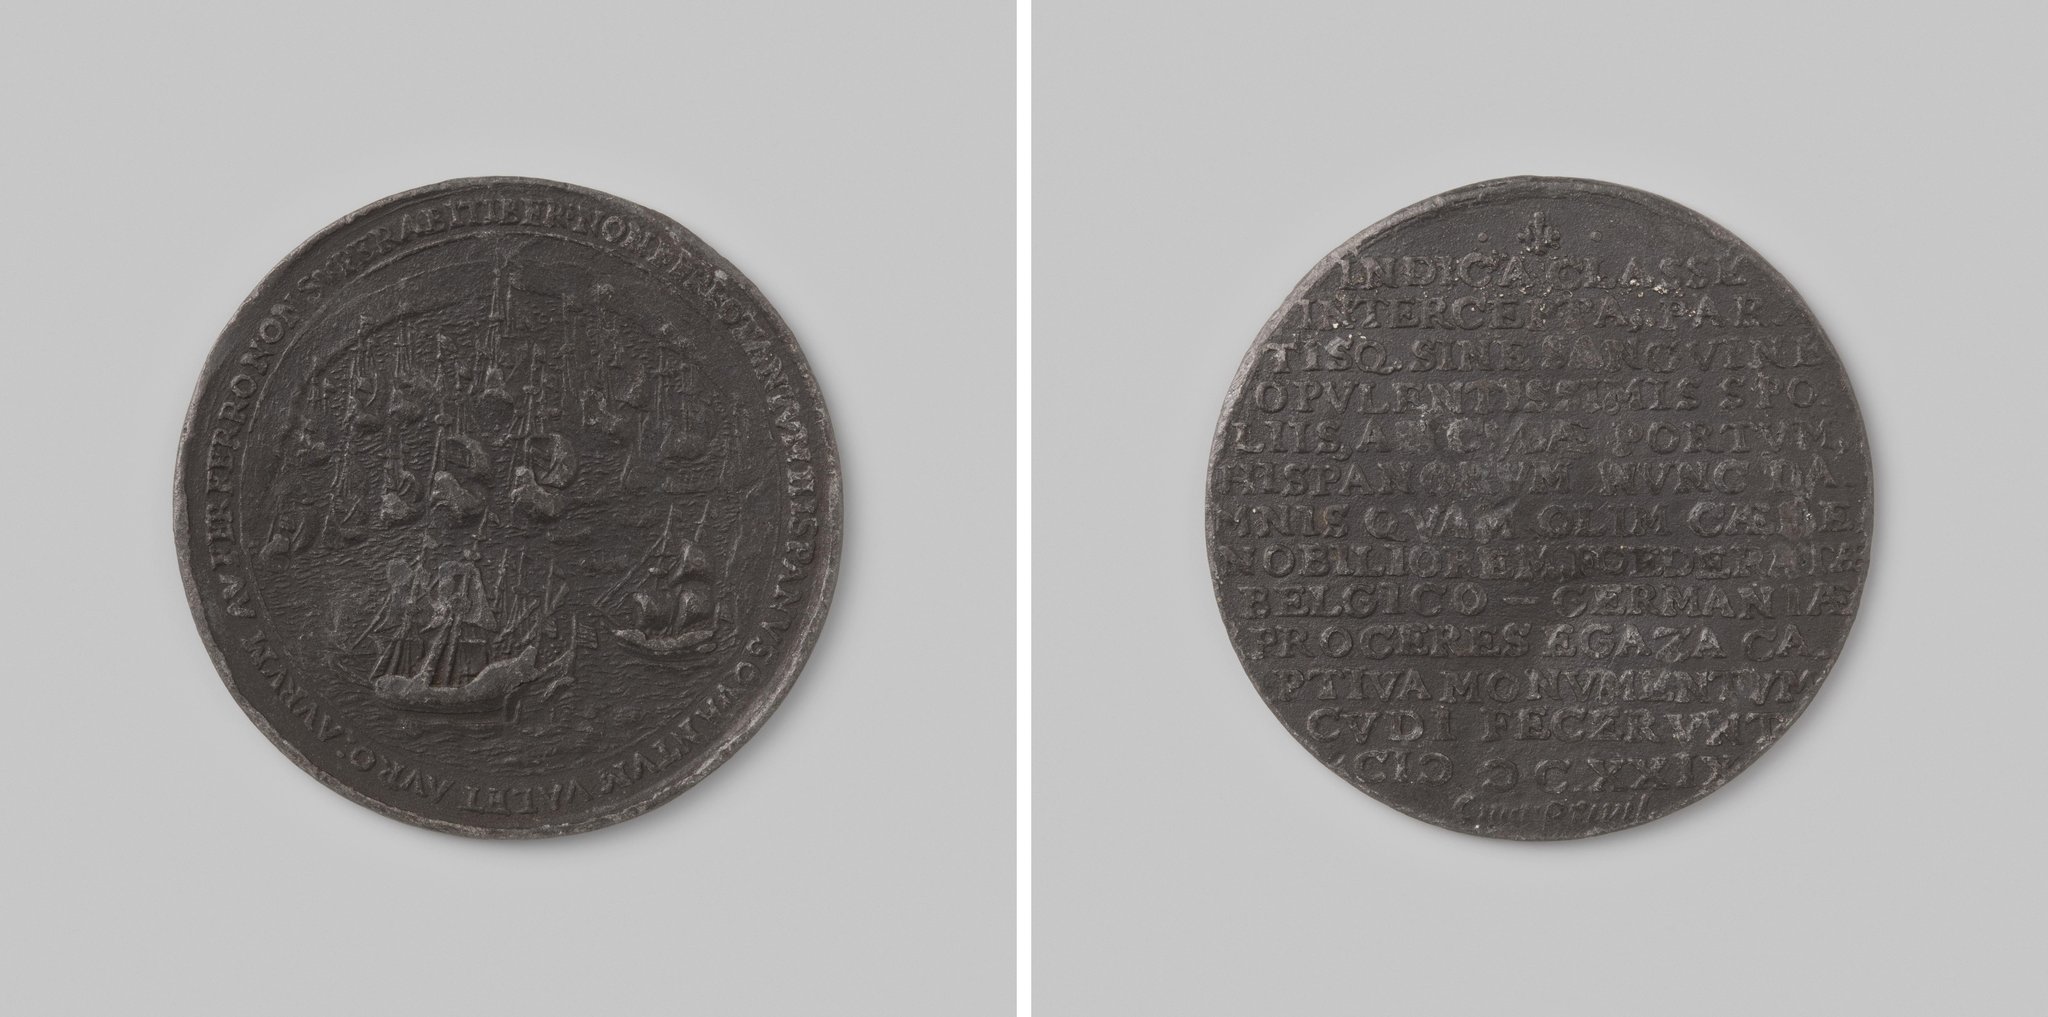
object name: history medal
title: Overmeestering van de Spaanse Zilvervloot door Piet Hein 1628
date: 1619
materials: tin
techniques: casting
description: Tinnen penning, op de voorzijde een zeeslag in een baai, met omschrift, op de keerzijde veertien regels tekst.